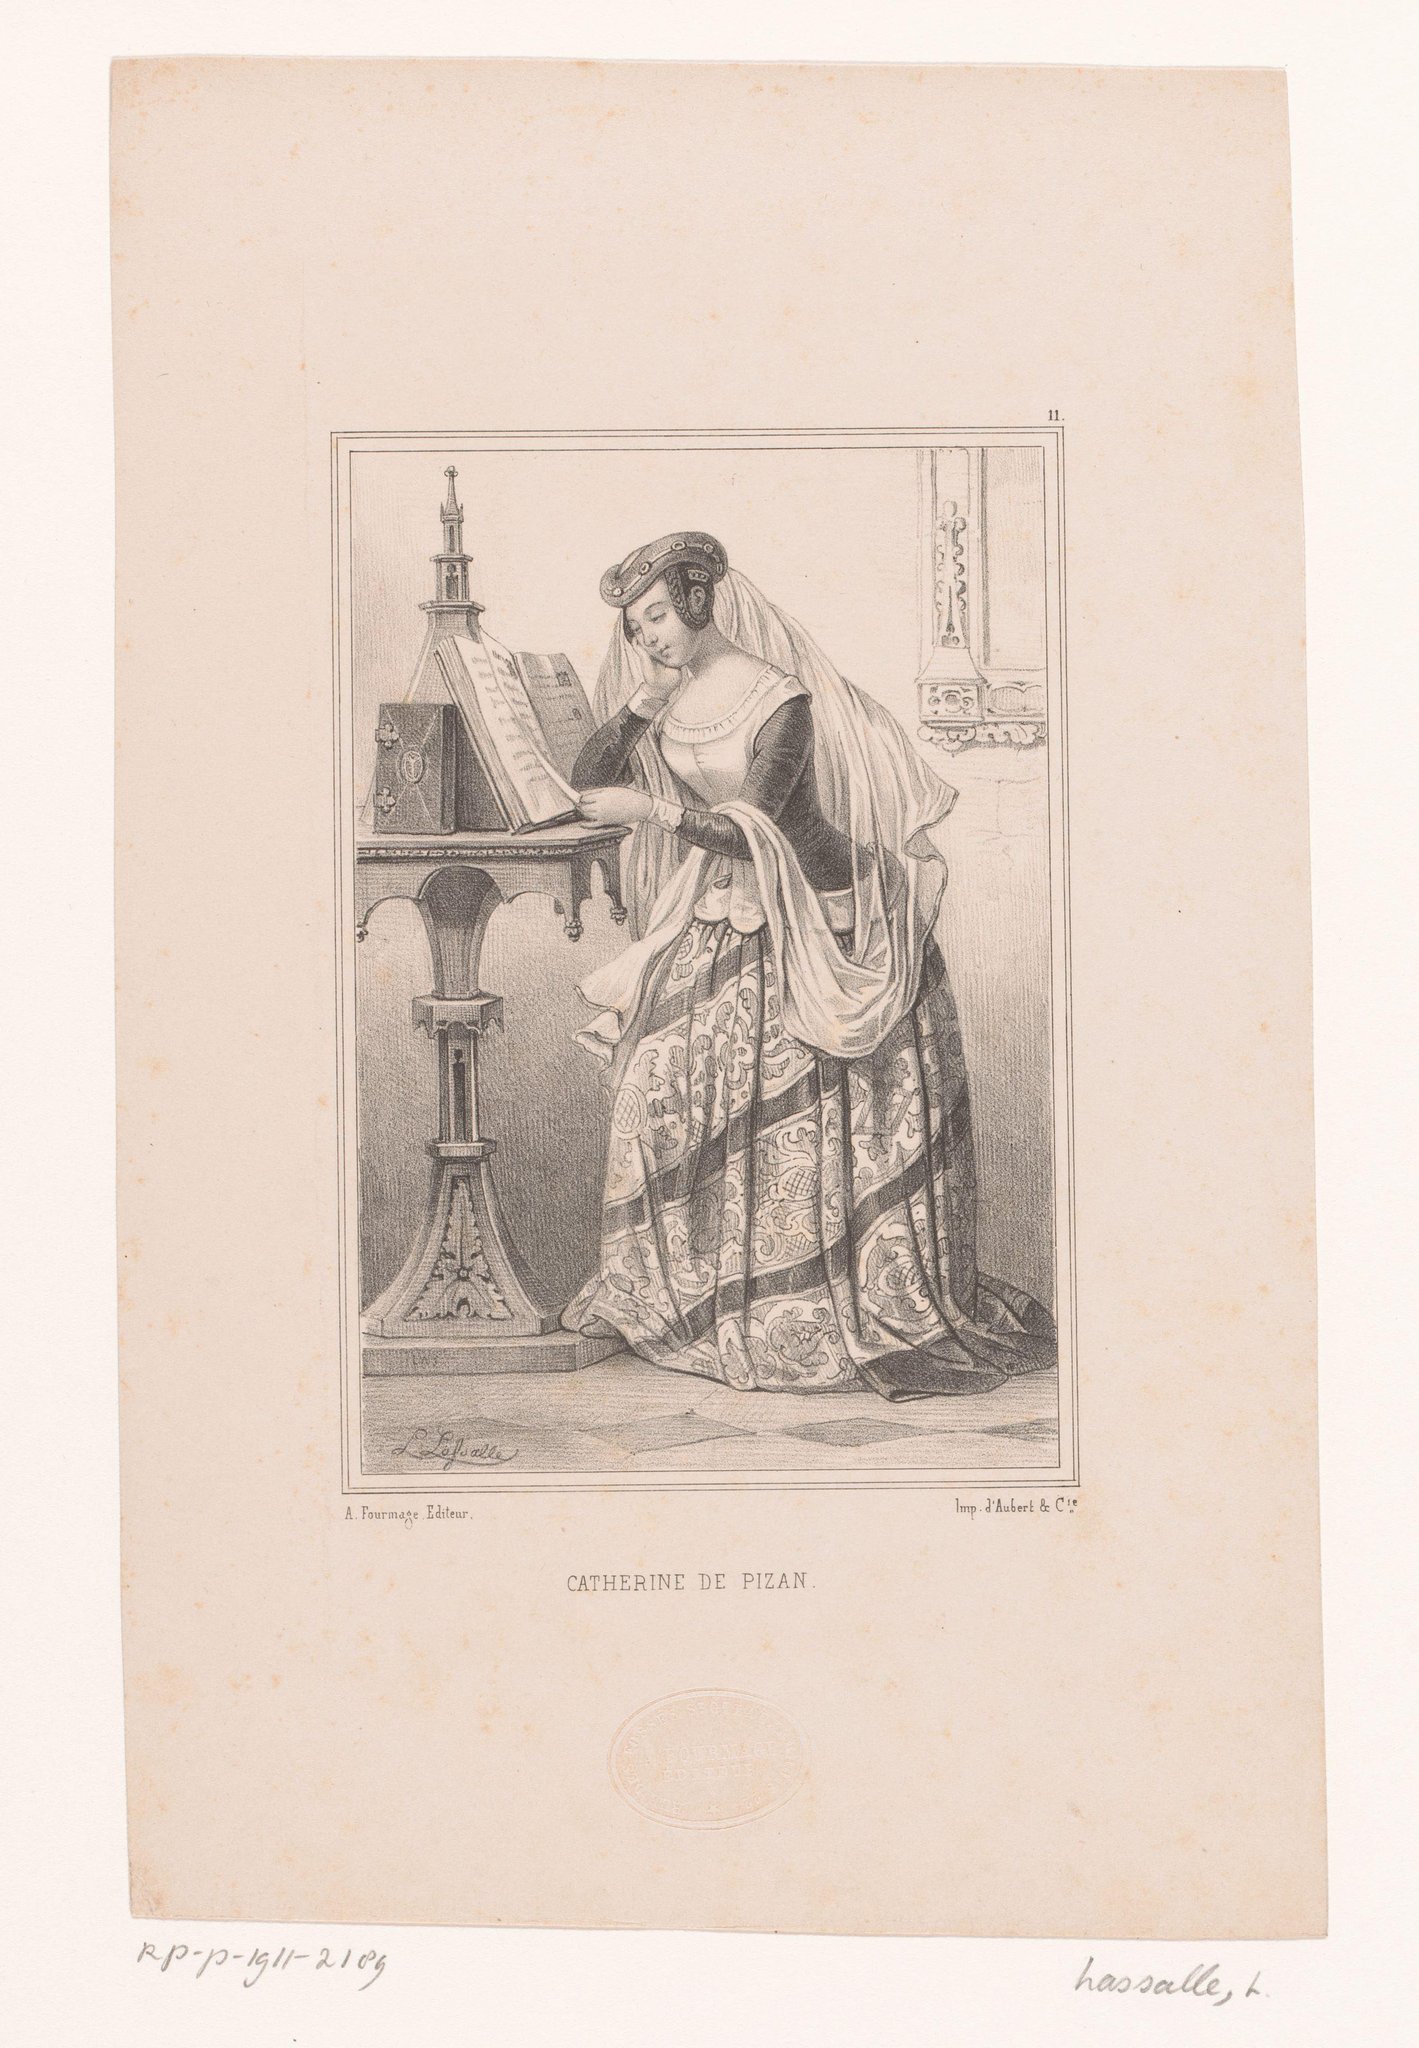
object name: print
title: Christine de Pizan aan een lessenaar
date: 1841-1850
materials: paper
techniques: lithograph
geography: paris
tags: historical persons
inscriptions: collector's mark: Lugt 2228a, check stamp: Lugt 5285